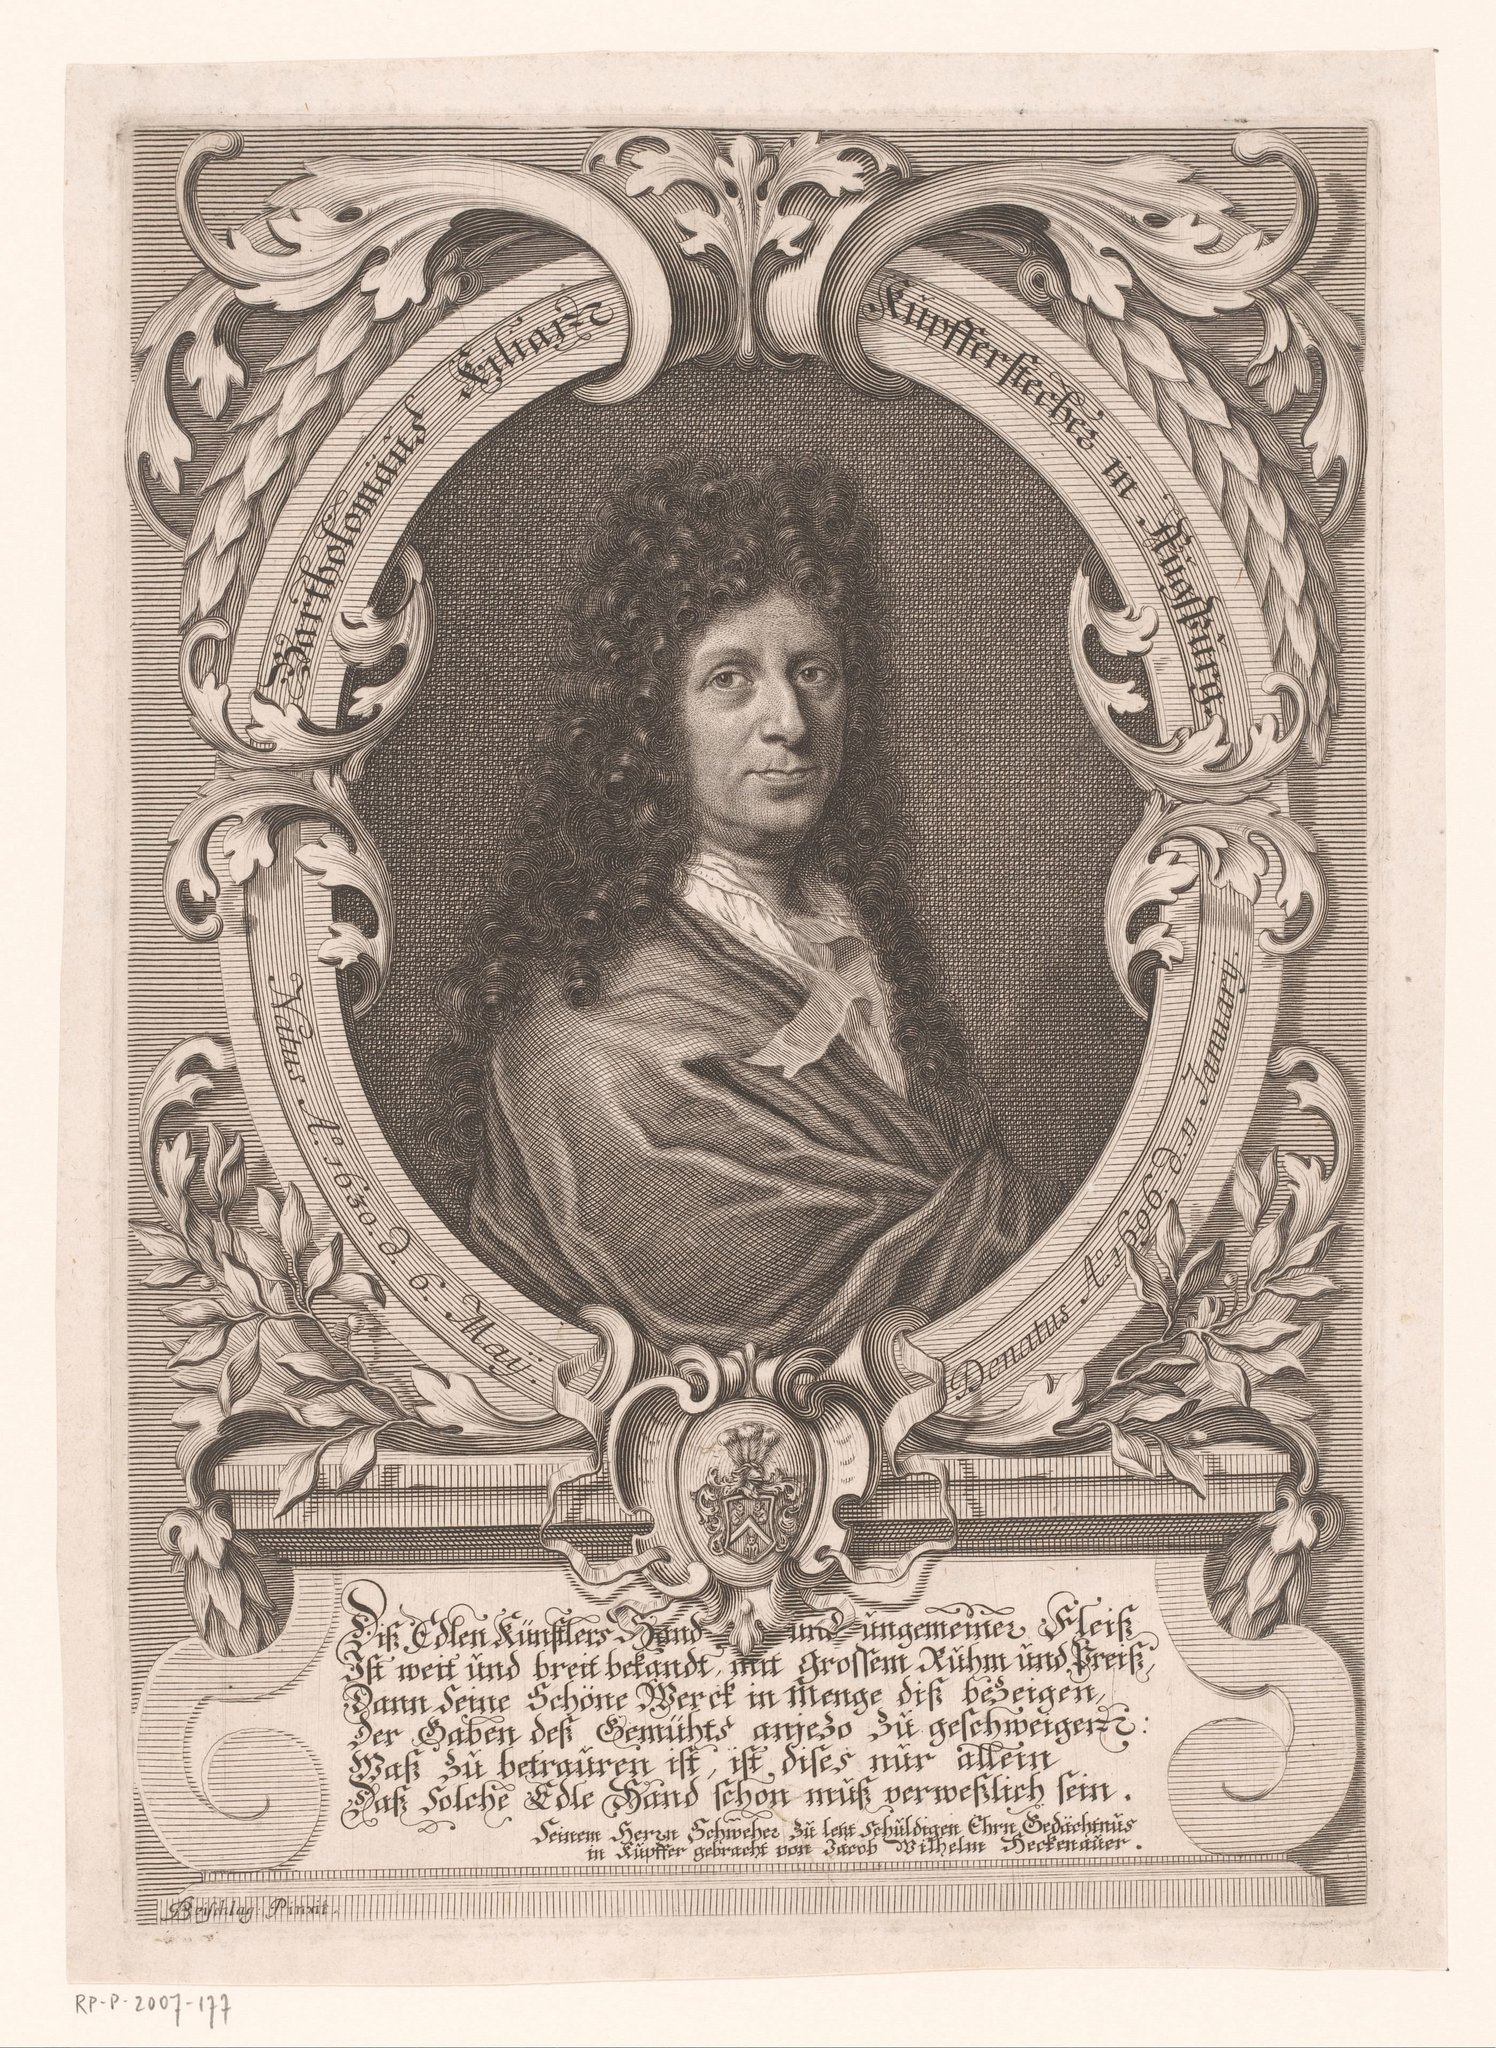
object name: print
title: Portret van Bartholomäus Kilian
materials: paper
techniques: engraving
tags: print maker, draughtsman, publisher, bartholomäus kilian (ii), trees: laurel (branch, stick), portrait, self-portrait of graphic artist, armorial bearing, heraldry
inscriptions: collector's mark: Lugt 2228, collector's mark: Lugt 2760